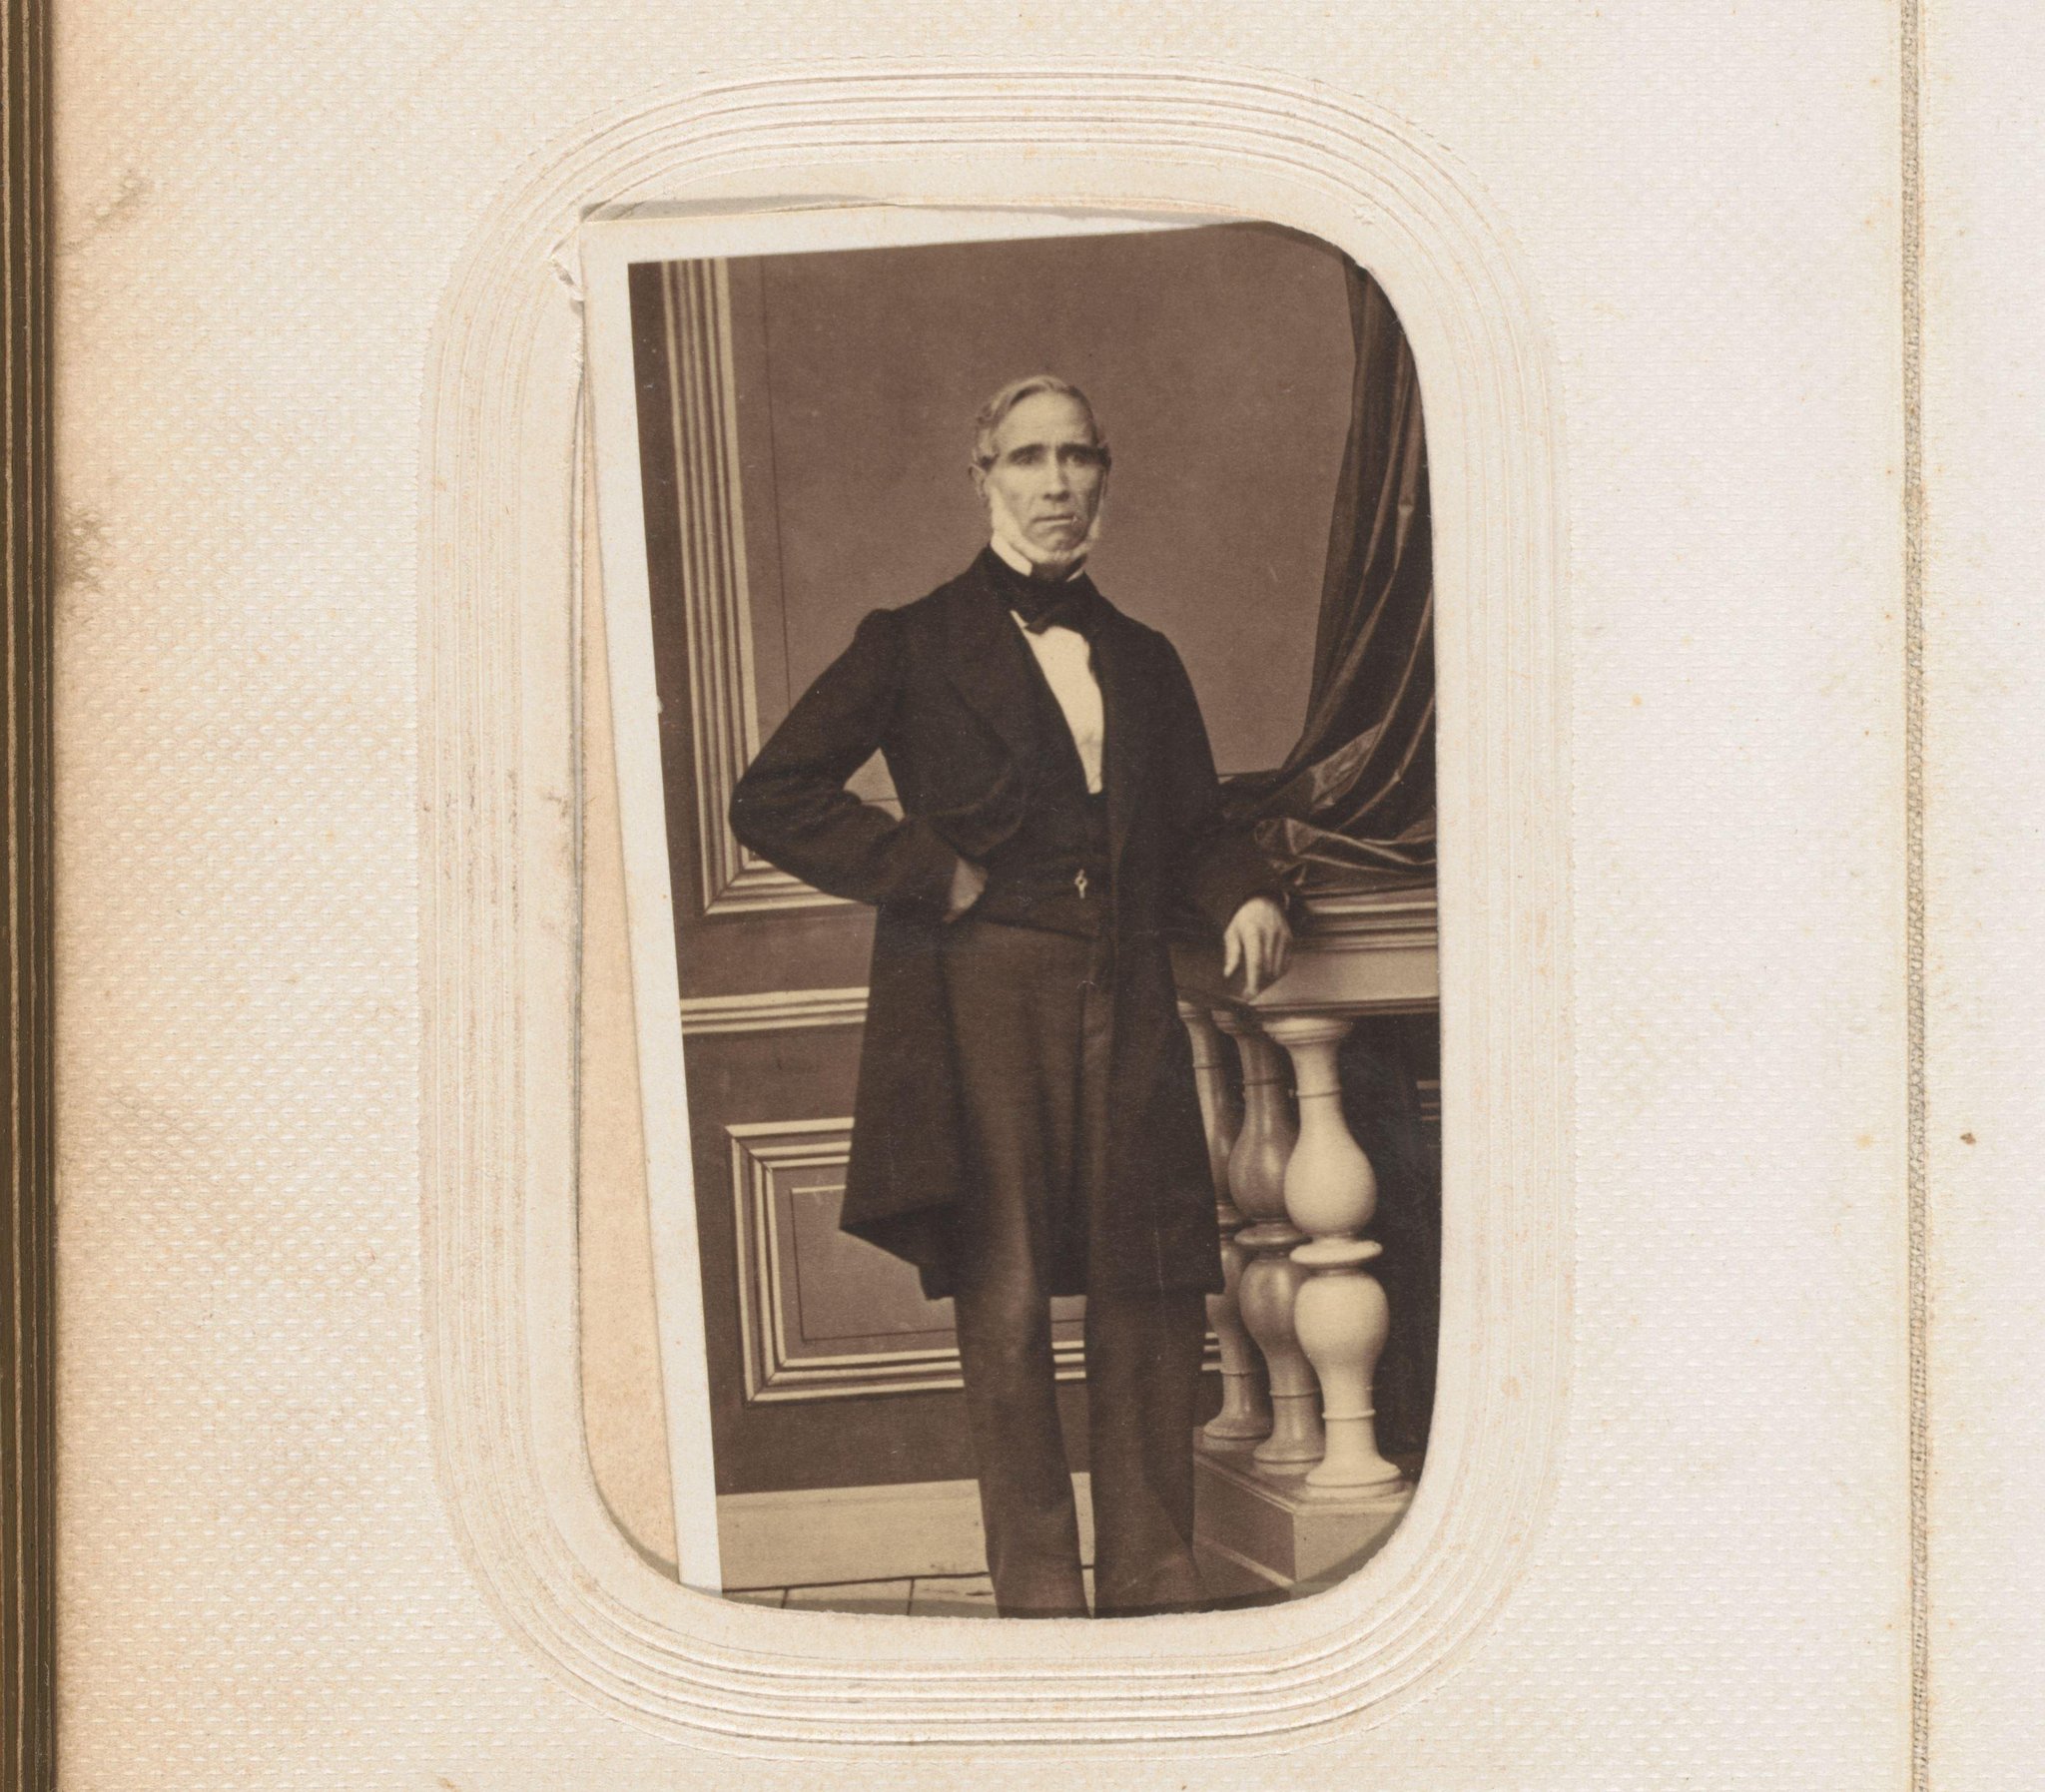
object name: carte de visite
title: Portret van een staande man met baard bij balustrade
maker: Anonymous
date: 1855-1865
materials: cardboard, photographic support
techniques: albumen print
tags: adult man, historical persons, beard